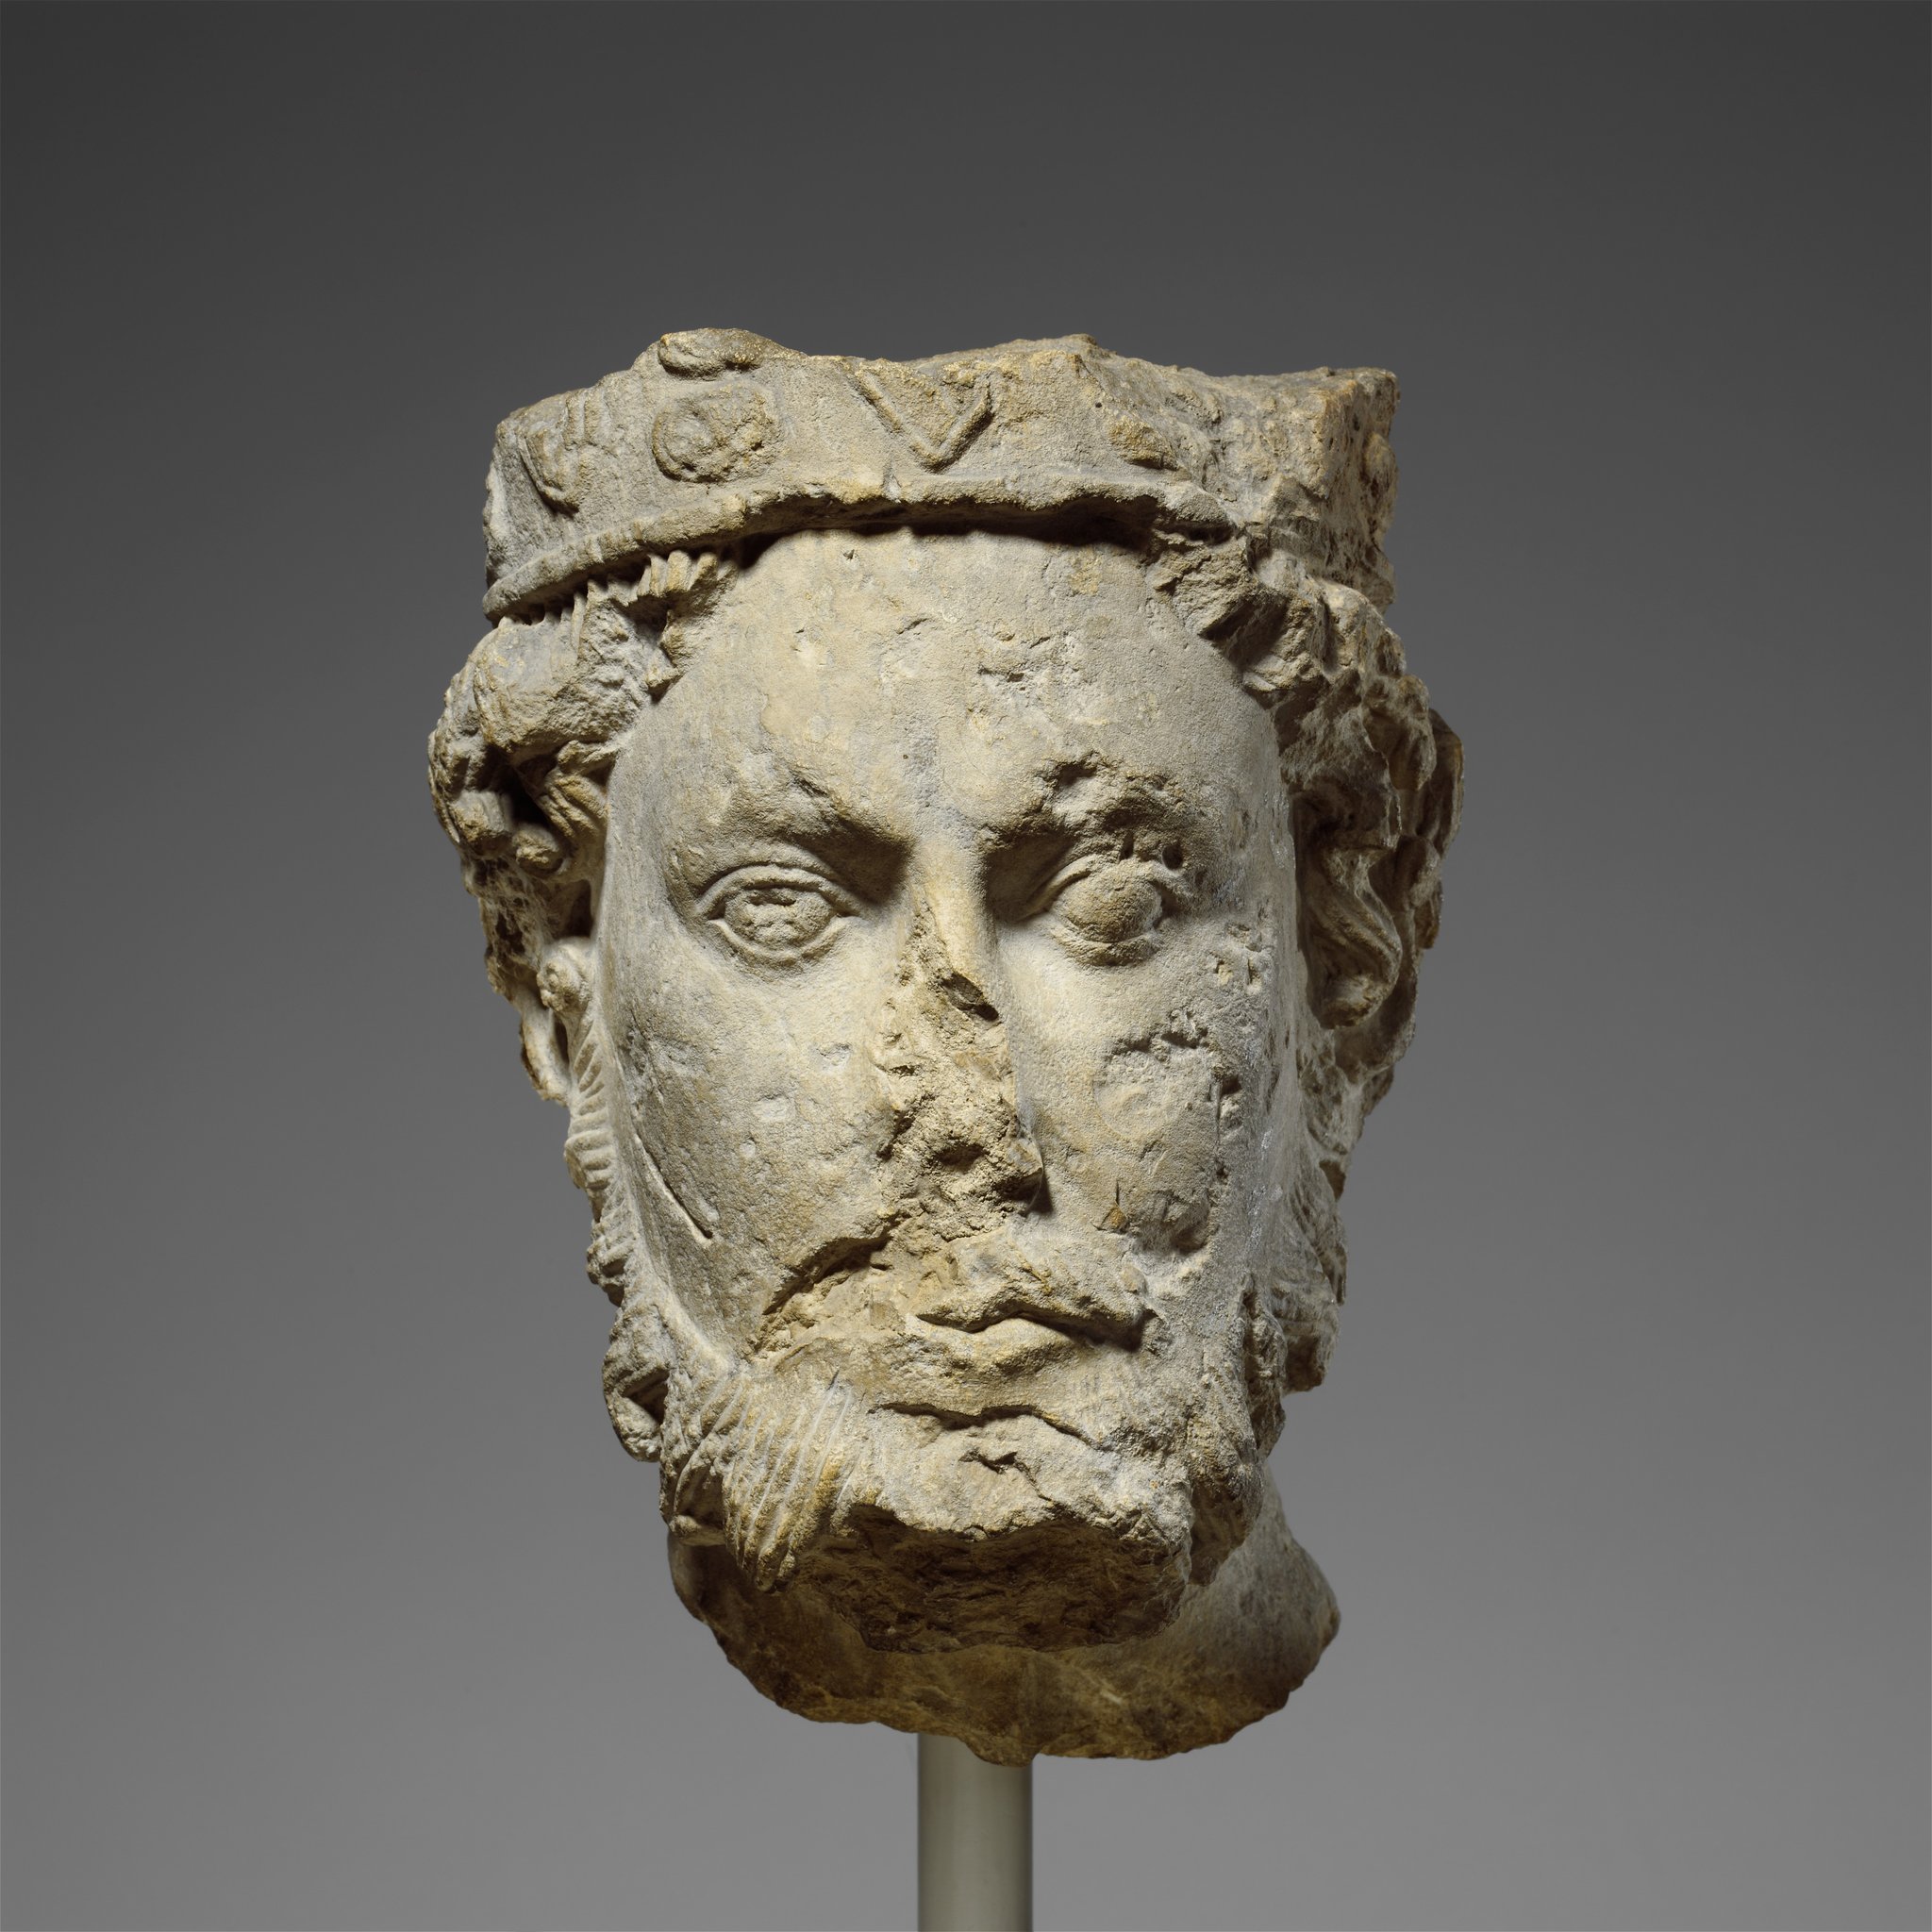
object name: statue head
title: Head of a King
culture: french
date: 1180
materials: limestone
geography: france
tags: kings,heads